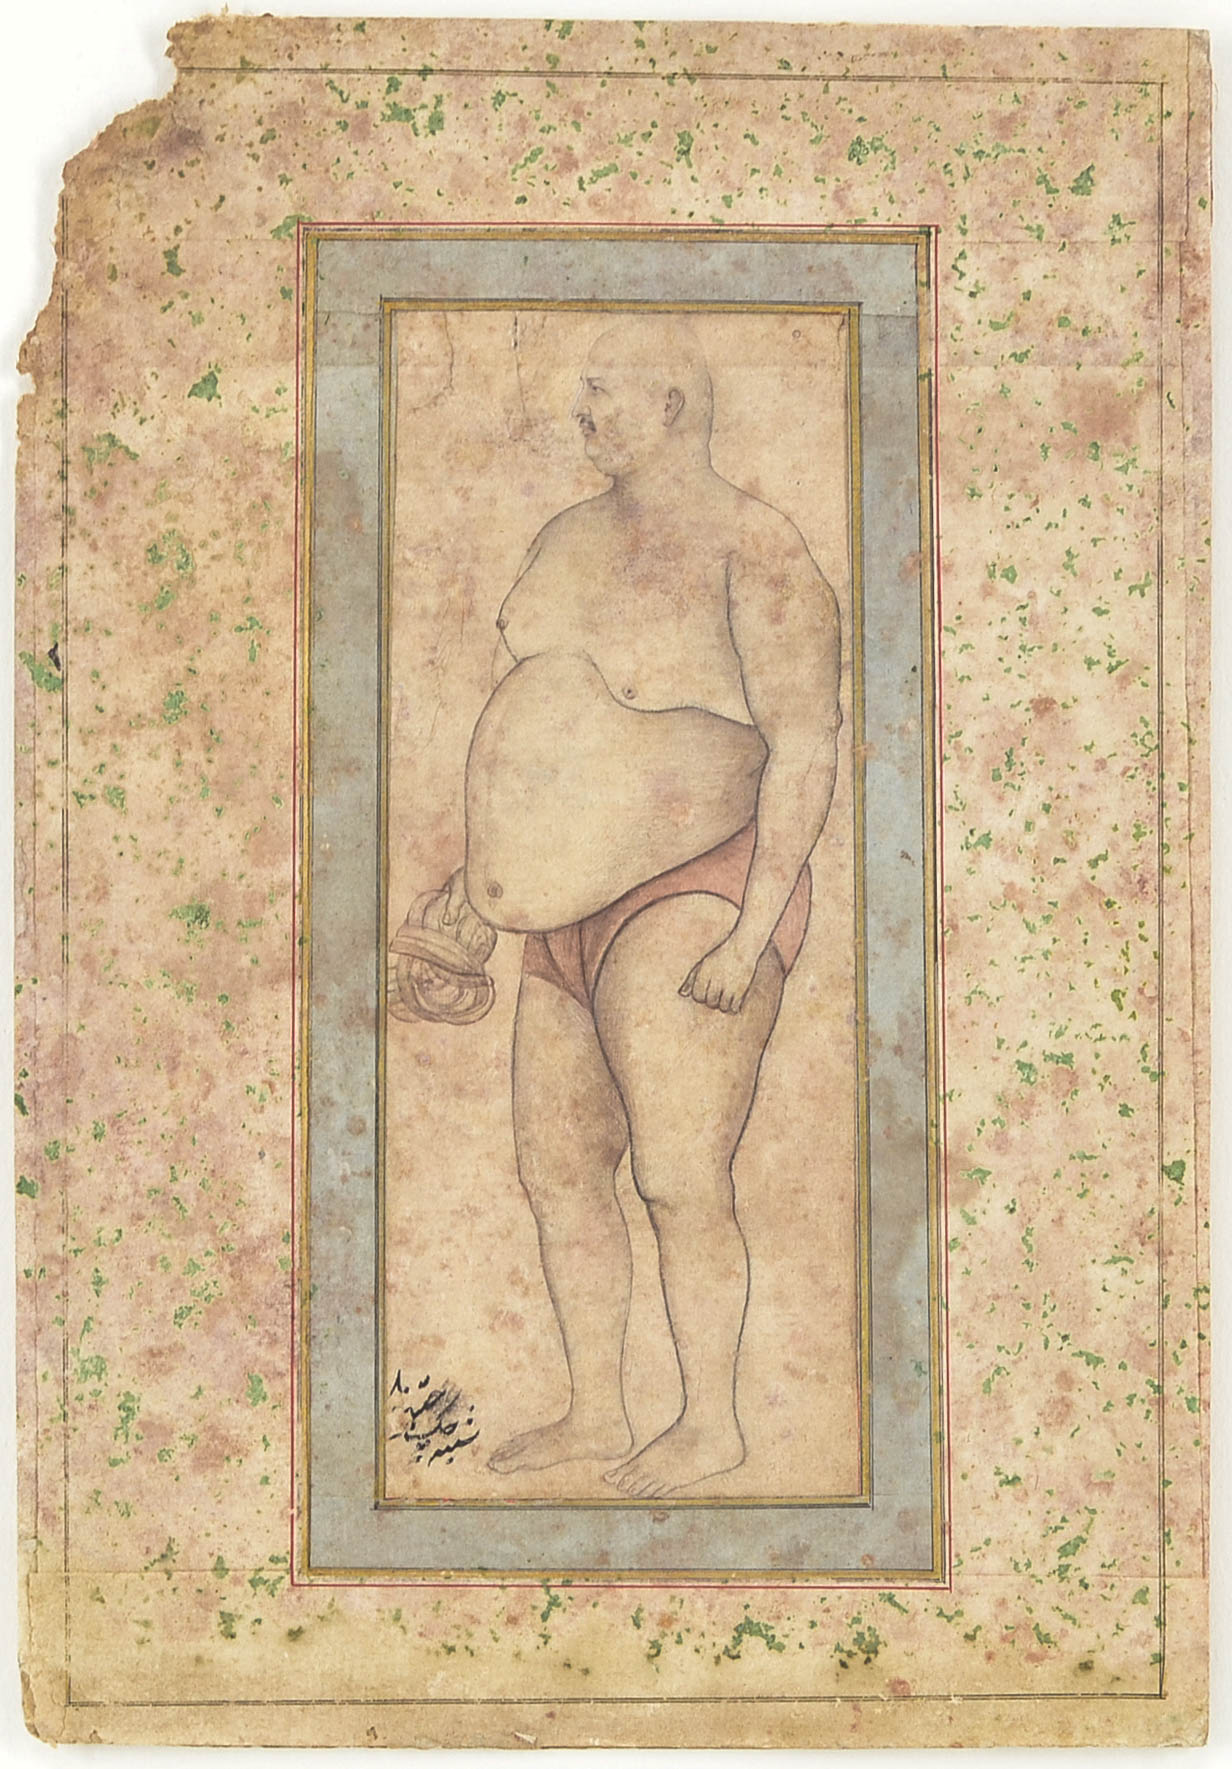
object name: illustrated single work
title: Portrait of Chuk the Wrestler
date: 1660-1675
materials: gold, ink, paper, watercolor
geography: india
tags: men,athletes,wrestling